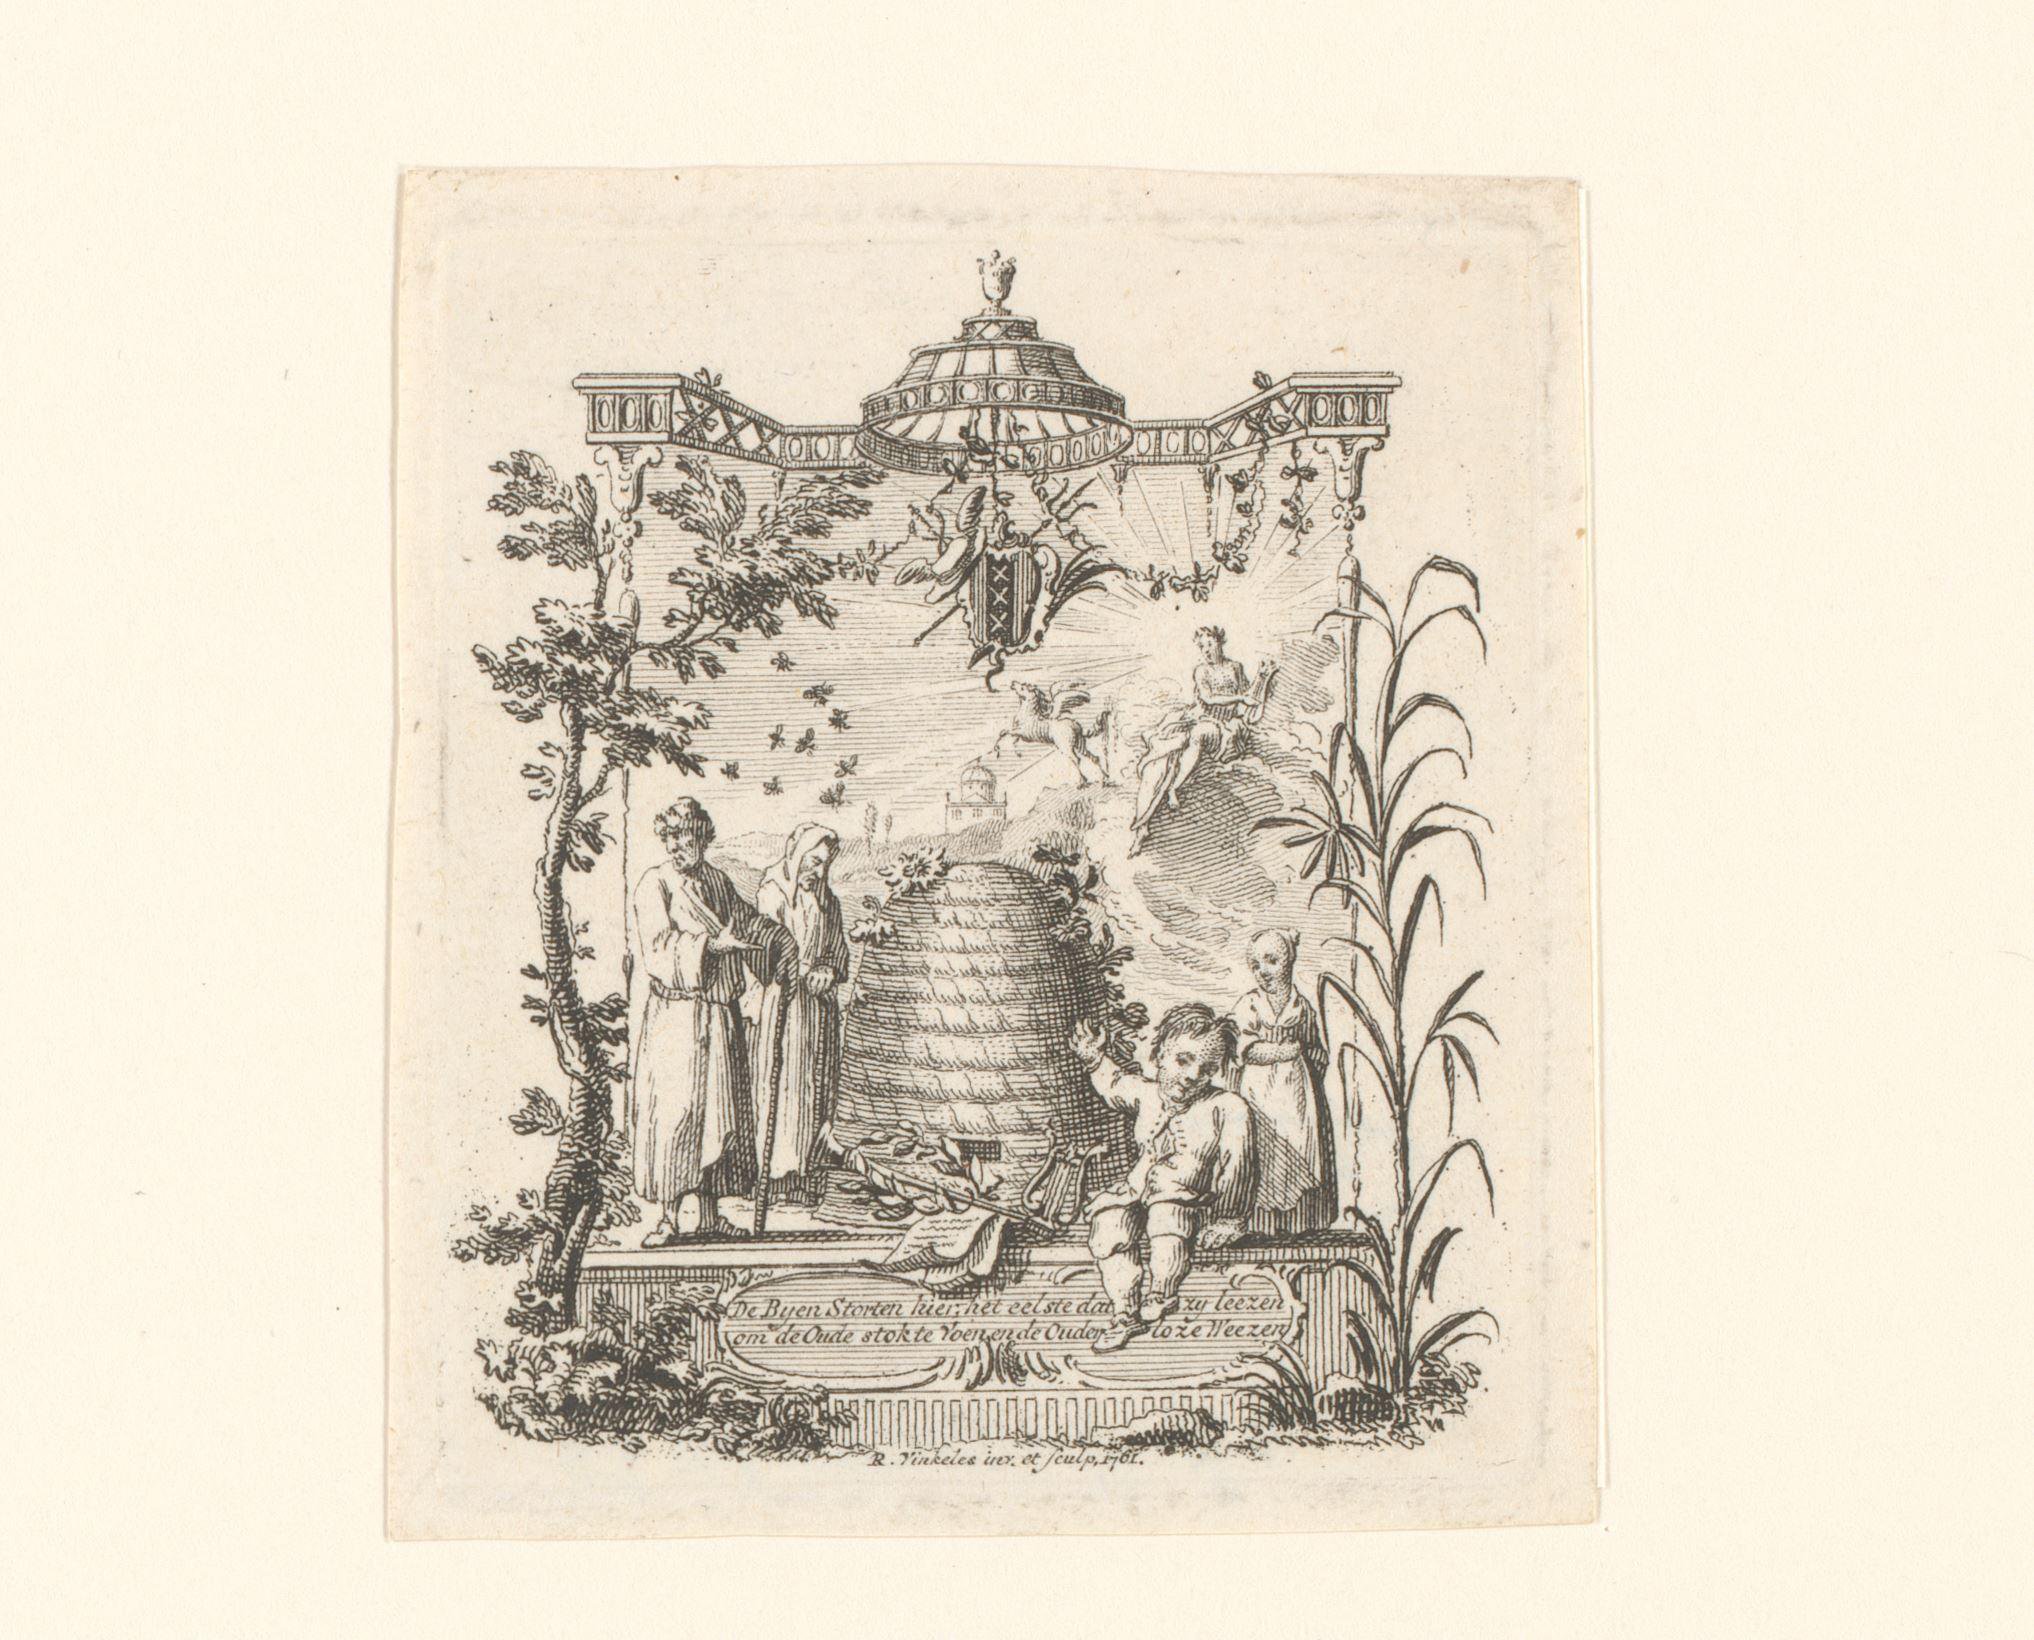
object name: print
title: Figuren rondom een bijenkorf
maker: reinier vinkeles (i)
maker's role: draughtsman, print maker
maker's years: 1741-1816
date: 1761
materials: paper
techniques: etching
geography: amsterdam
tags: coat of arms (as symbol of the state, etc.) (+ city; municipal), pegasus, the winged horse, bee-hive, apollo playing the lyre, apollo citharoedus, amsterdam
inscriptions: collector's mark: Lugt 2228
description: Met tweeregelig vers in het Nederlands onder de voorstelling. Boven de bijenkorf het stadswapen van Amsterdam. Rechts Pegasus en Apollo op een wolk.